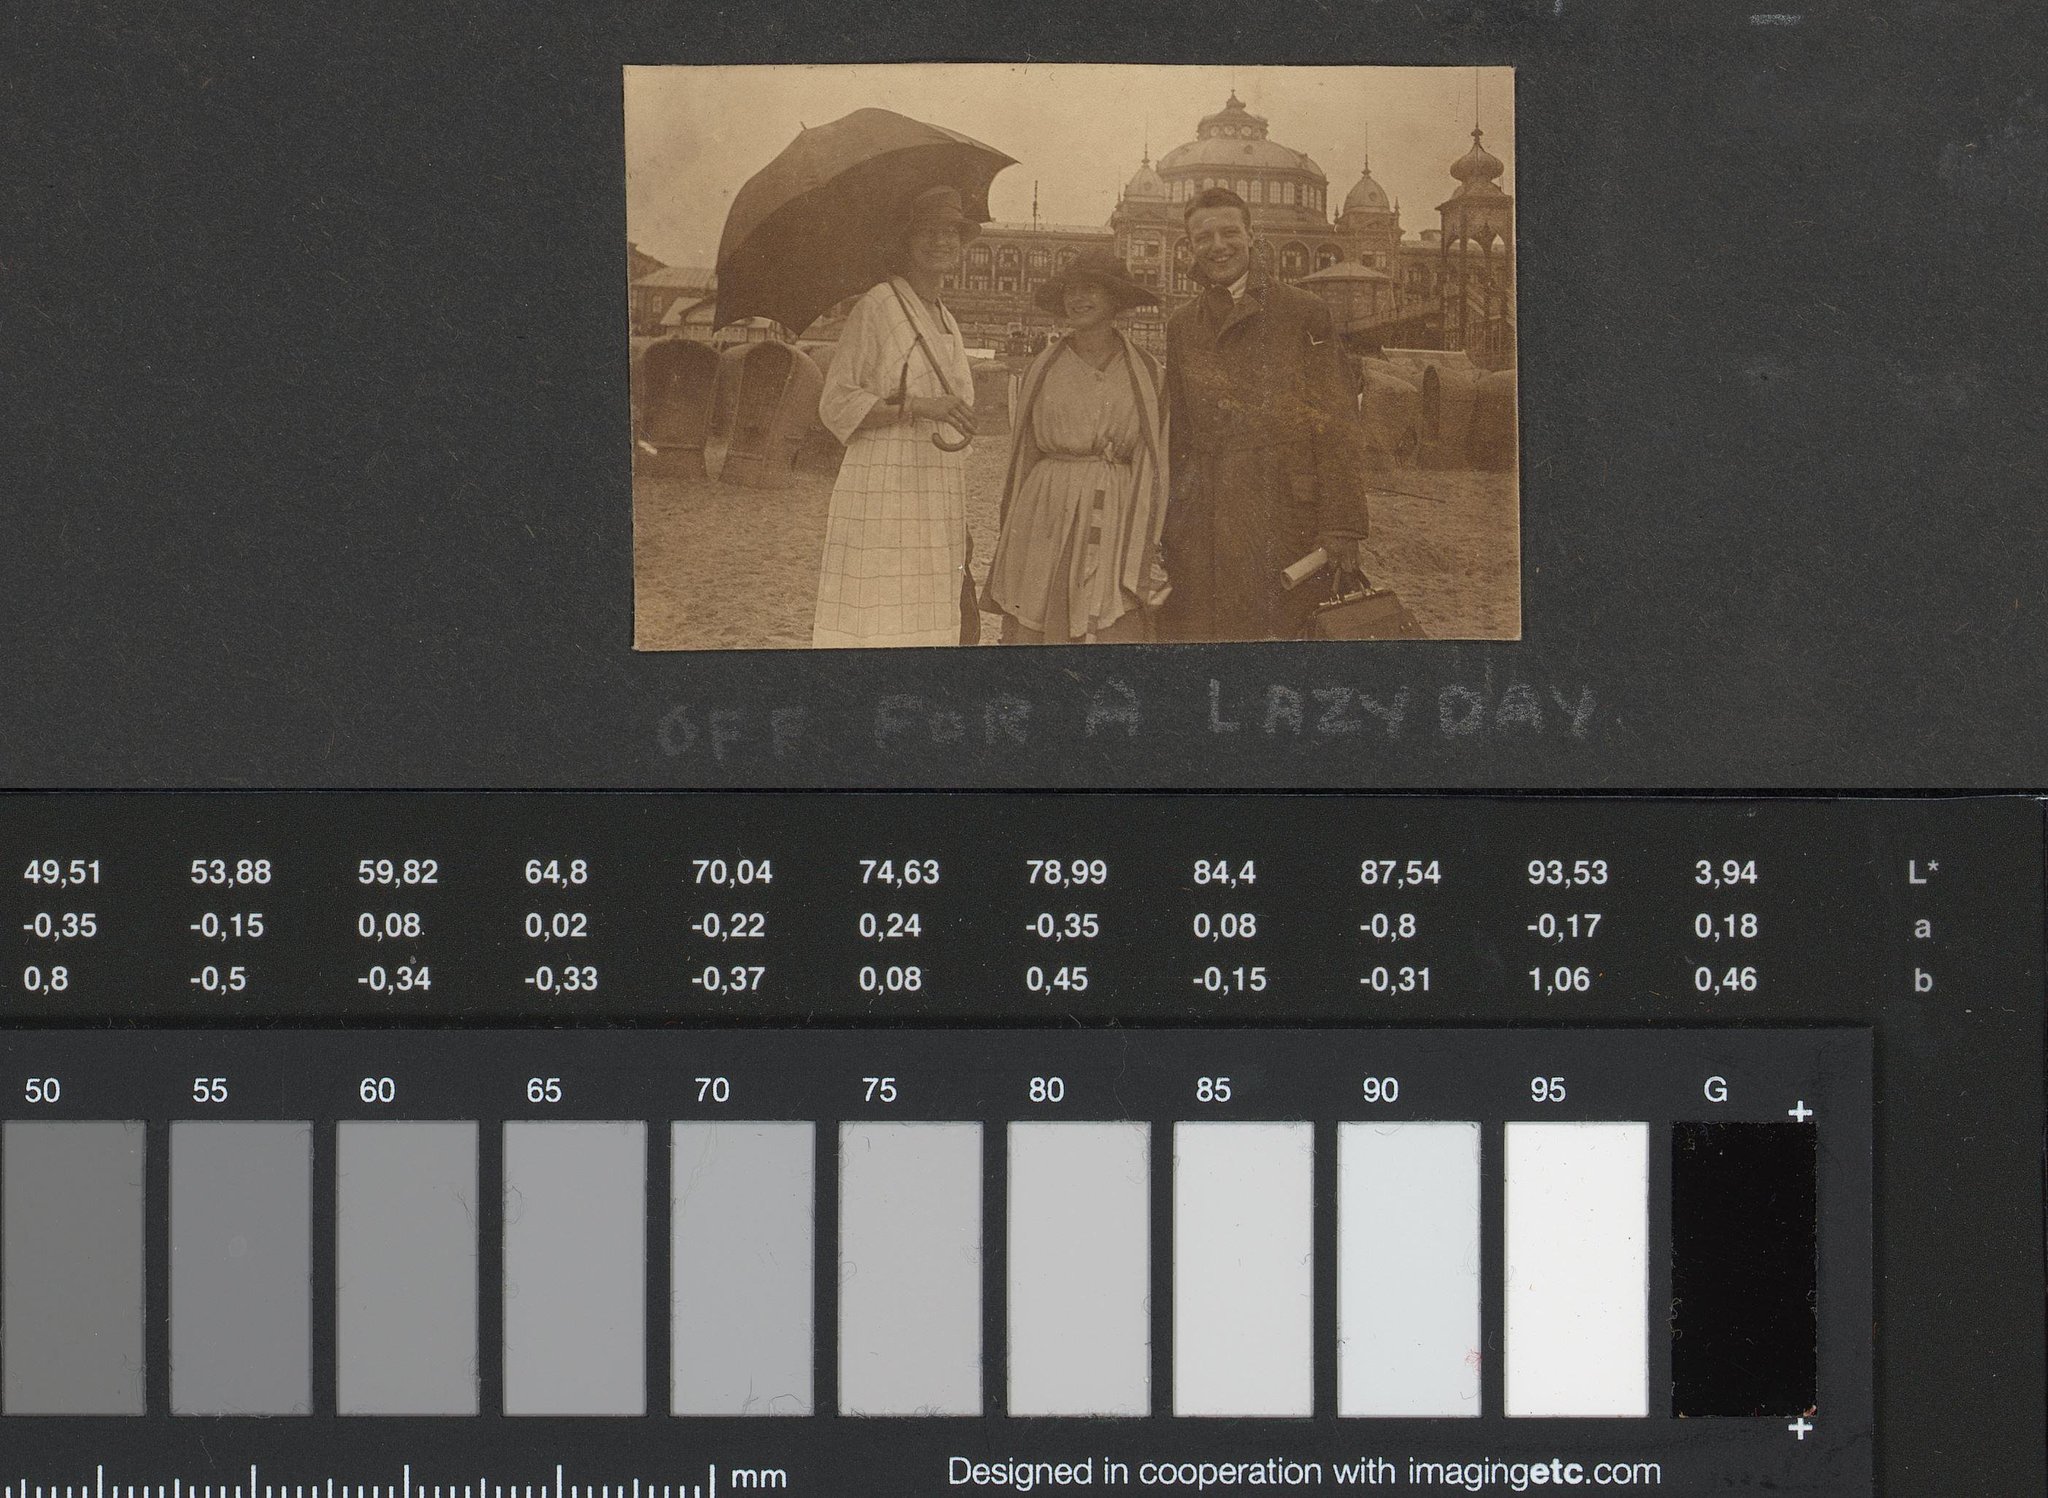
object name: album leaf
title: Twee vrouwen en een man voor het Kurhaus te Scheveningen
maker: Anonymous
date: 1920-1925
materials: paper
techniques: gelatin silver print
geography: south holland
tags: adult woman, adult man, civic architecture; edifices; dwellings